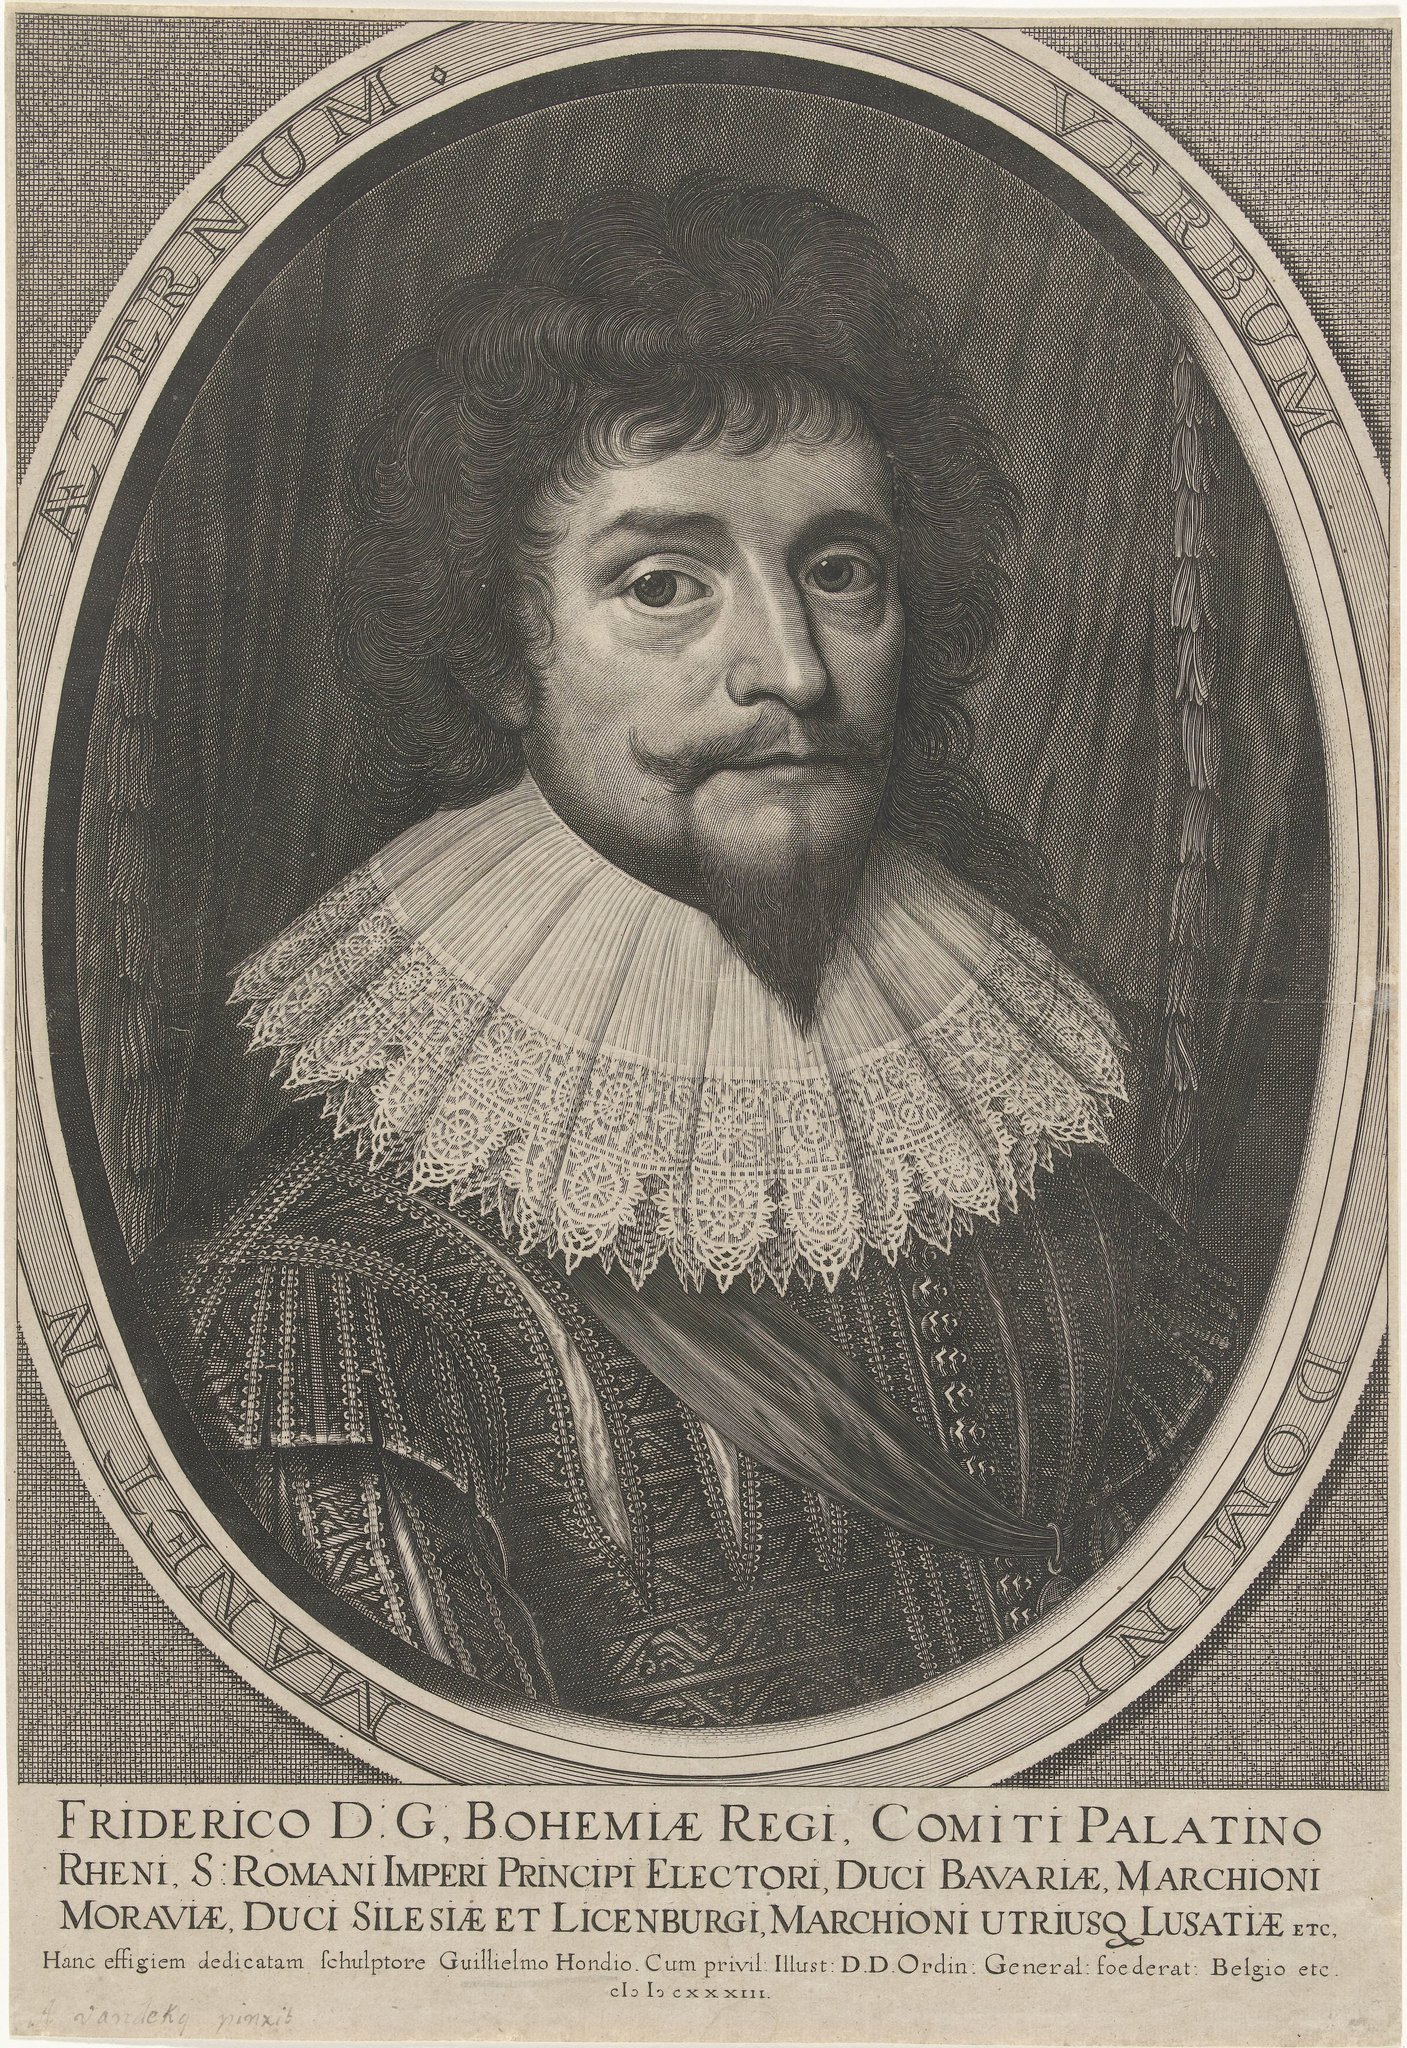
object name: print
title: Portret van Frederik V, keurvorst van de Palts, koning van Bohemen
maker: willem hondius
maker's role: print maker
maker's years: 1597-1660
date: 1632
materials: paper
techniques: engraving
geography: the hague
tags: amberg, frederik v (keurvorst van de palts, koning van bohemen)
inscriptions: collector's mark: Lugt 2228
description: Buste naar rechts van Frederik V, keurvorst van de Palts, koning van Bohemen in een ovale omlijsting met randschrift in het Latijn. Onder het portret drie regels in het Latijn.